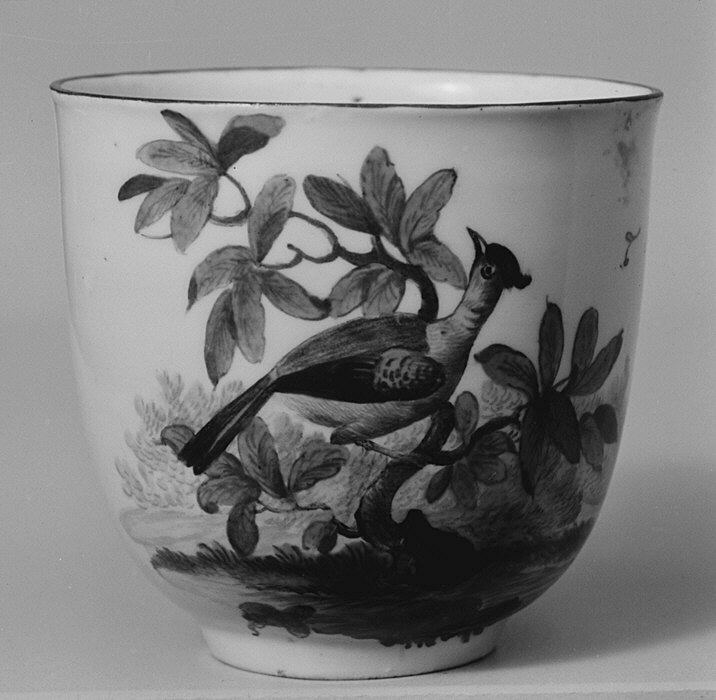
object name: cup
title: Cup (part of a service)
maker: frankenthal porcelain manufactory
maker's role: manufactory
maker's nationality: german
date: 1770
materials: hard paste porcelain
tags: birds,plants